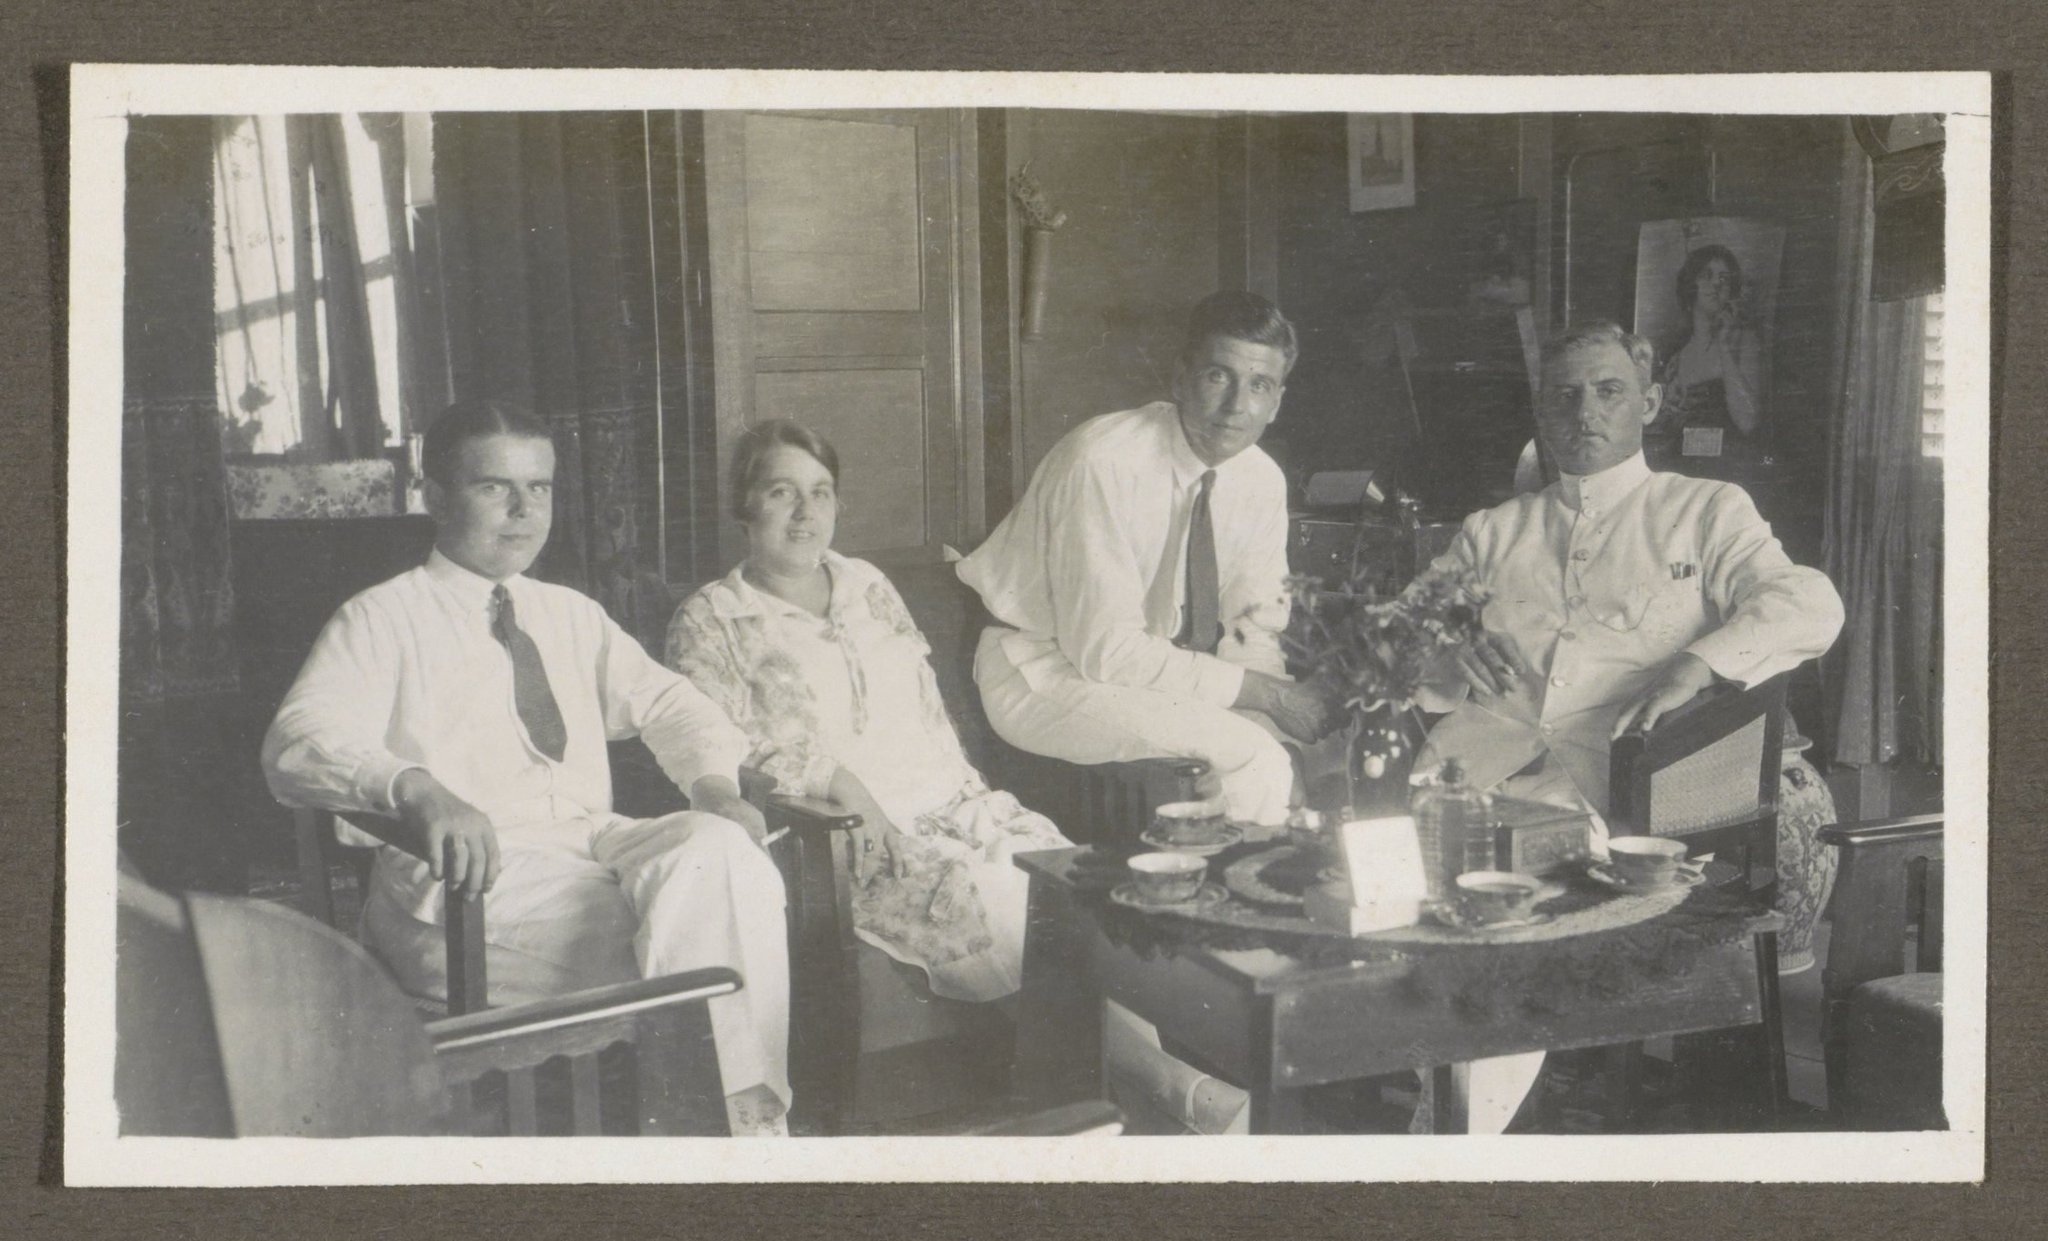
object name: photograph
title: Drie mannen en een vrouw rondom een tafel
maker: Anonymous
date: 1920-1930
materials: photographic support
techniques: gelatin silver print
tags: dutch east indies, the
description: Onderdeel van familiealbum Nederlands-Indië.